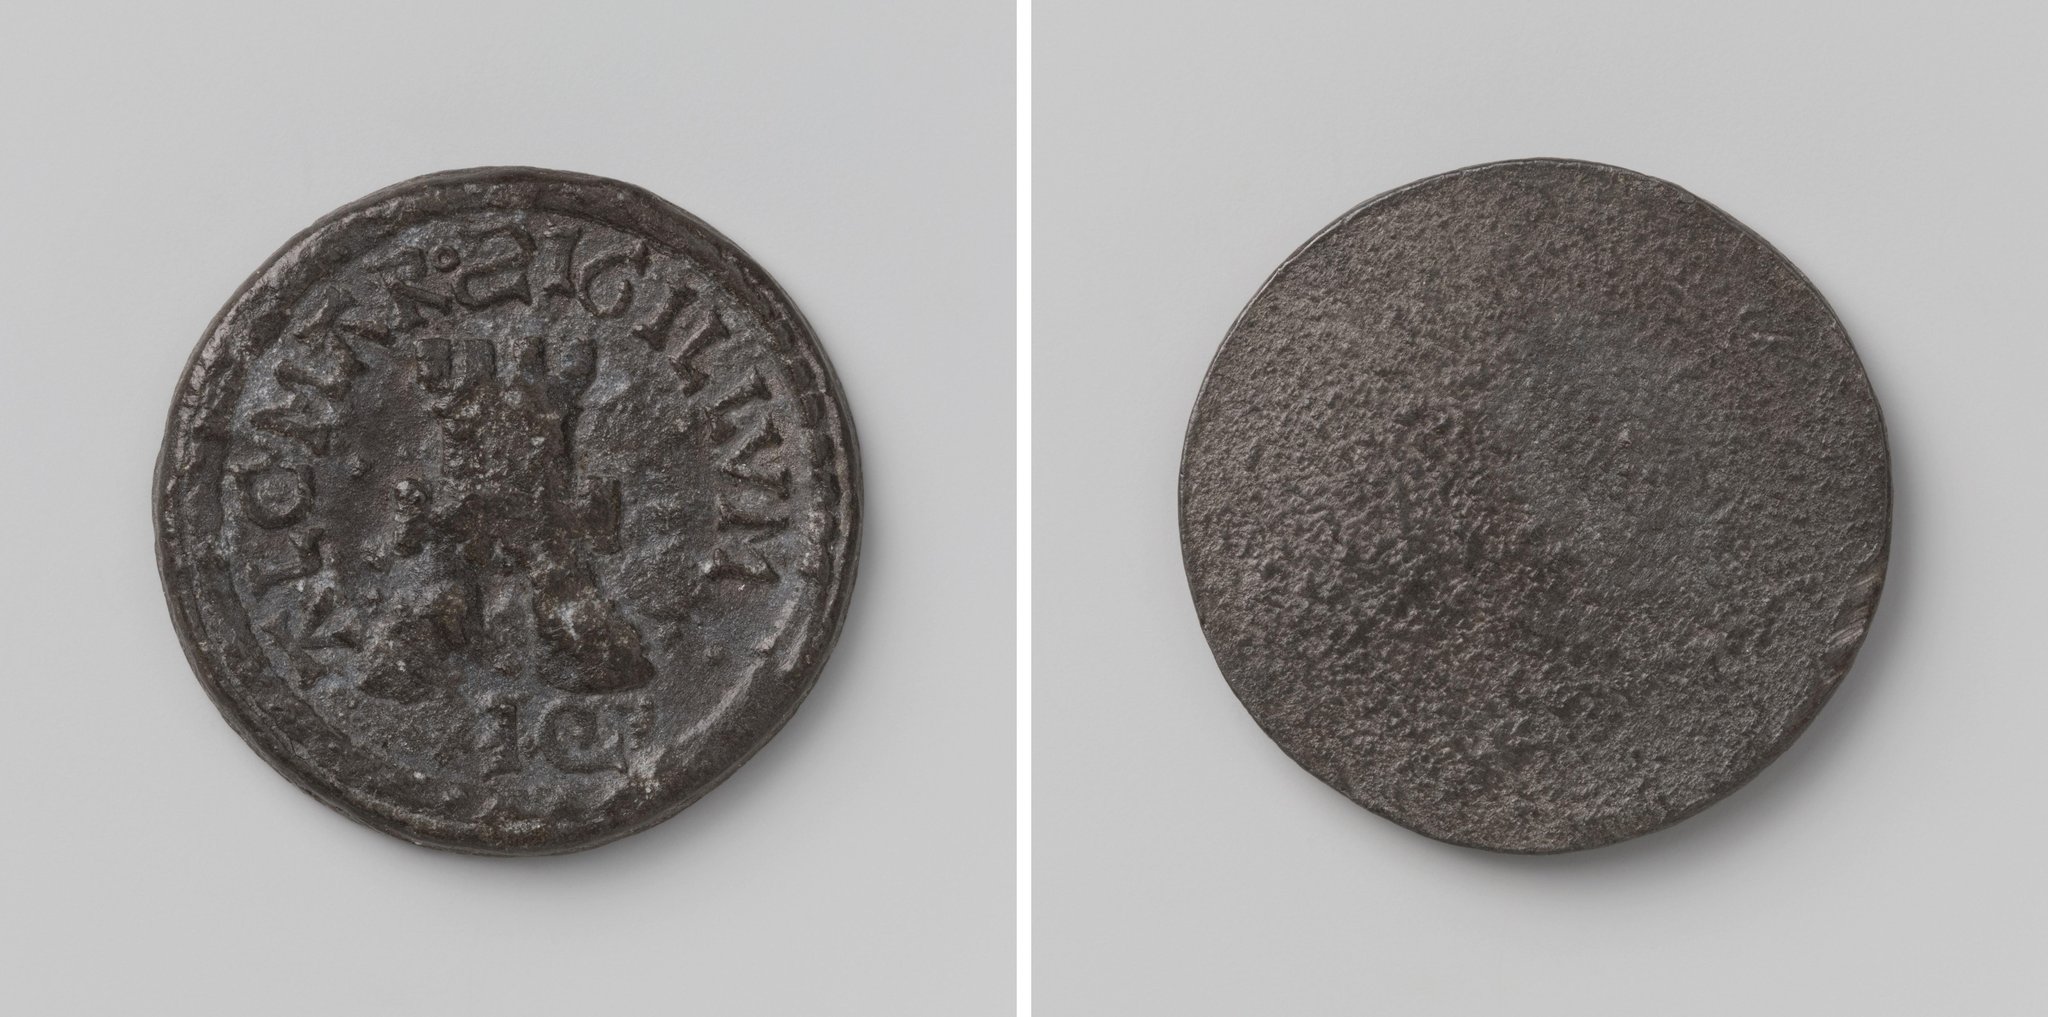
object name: siege coin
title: Daalder, noodmunt uit Alkmaar, geslagen tijdens het beleg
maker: Anonymous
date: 1509-1573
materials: tin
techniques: casting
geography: alkmaar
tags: alkmaar, beleg van alkmaar (1573)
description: eenzijdige noodmunt uit het beleg van Alkmaar. Voorzijde: burcht binnen omschrift en parelrand. Keerzijde: blanco